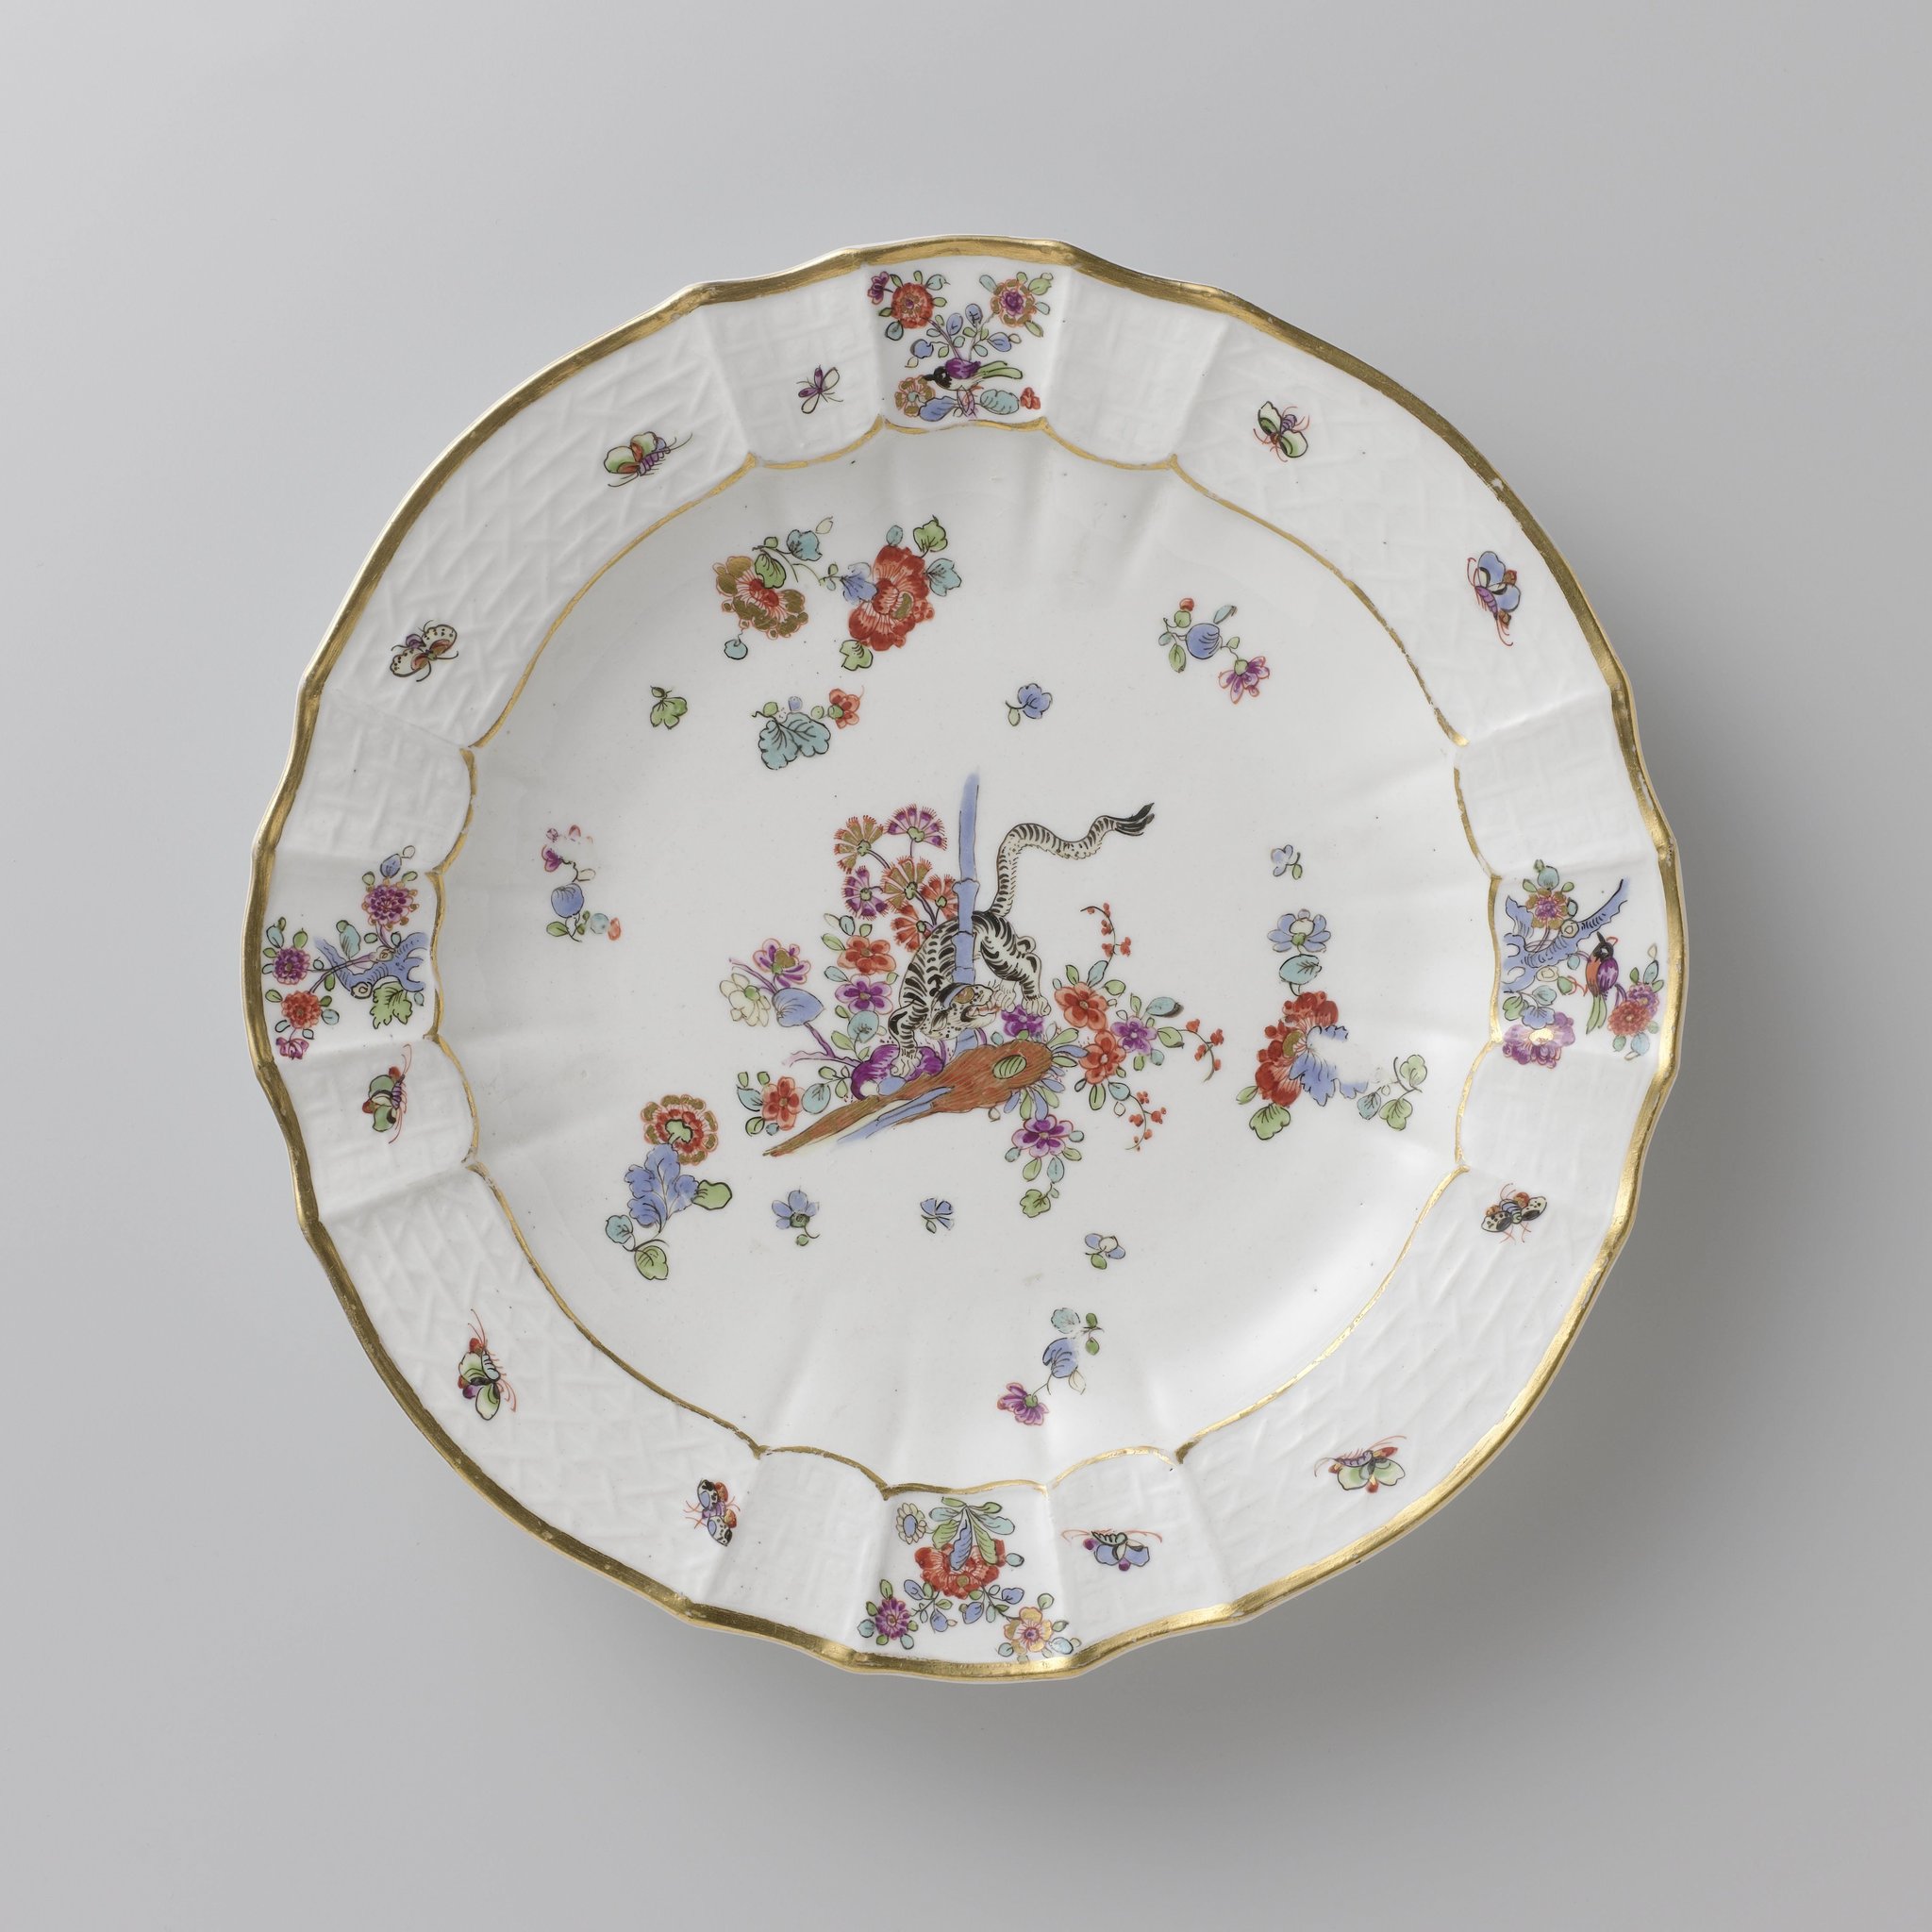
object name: eating drinking utensil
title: Rond bord, veelkleurig beschilderd met een Kakiemon-decor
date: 1740-1745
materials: porcelain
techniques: painted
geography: meissen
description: Rond bord van beschilderd porselein. Het bord is geribd en heeft een geschulpte rand. Het bord is beschilderd met een tijger die om een blauwe bamboestengel tussen bloemen is gedraaid, gestrooide Indianische Blumen, vlinders en takken waarop vogels. De rand is versierd met het 'Altbrandenstein'-patroon. Het bord is gemerkt.